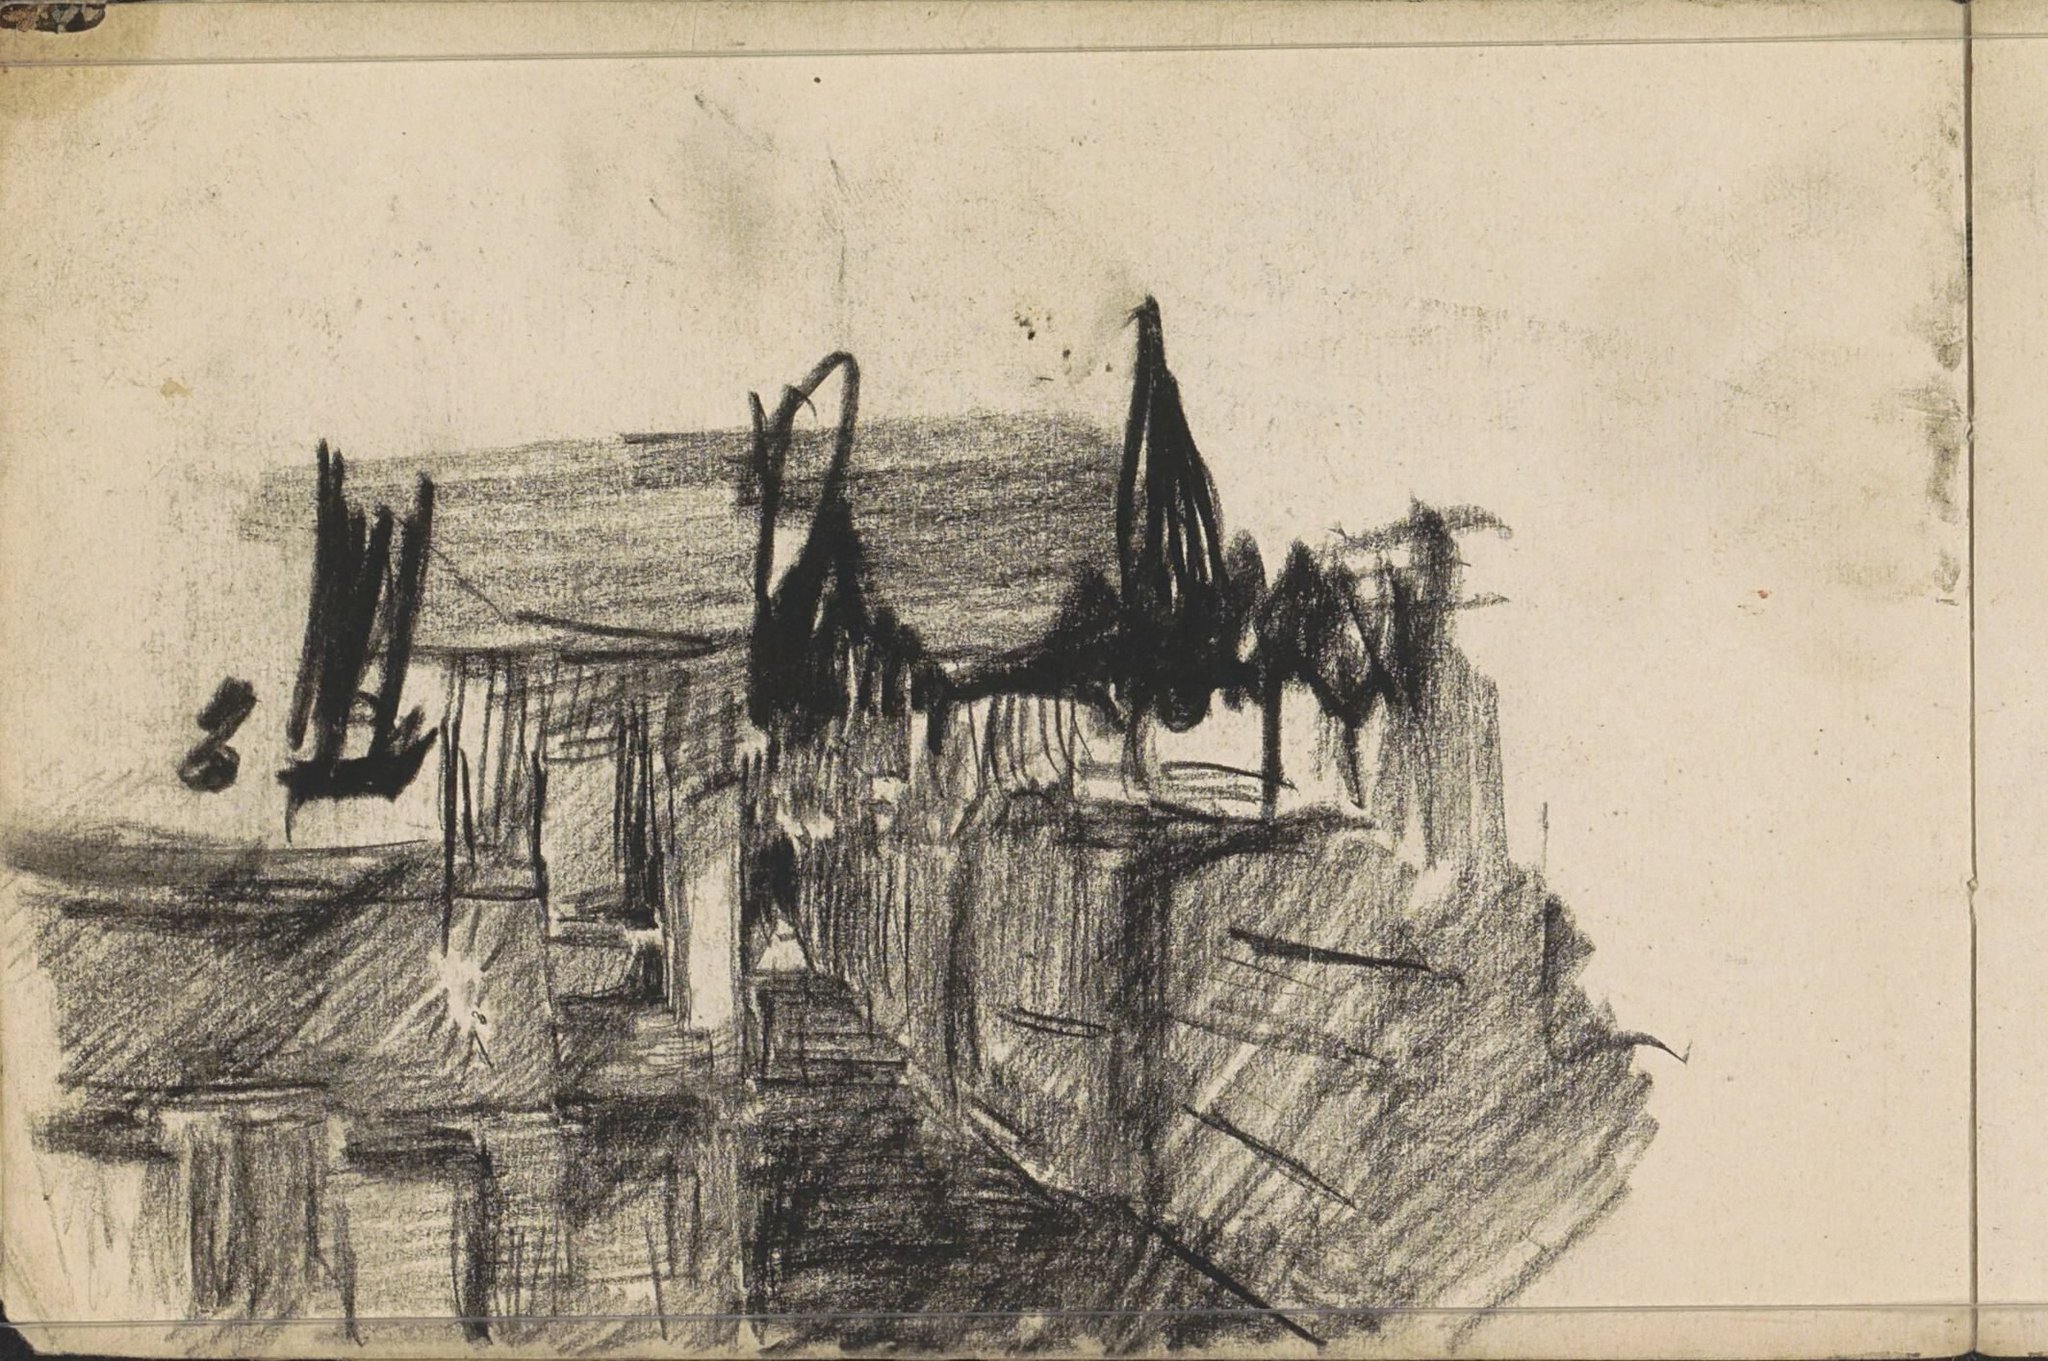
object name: sketchbook leaf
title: Straatgezicht met figuren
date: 1875-1934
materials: chalk, paper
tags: evening, street (+ city(-scape) with figures, staffage), paris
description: Mogelijk bij avond te Parijs. Pagina 4 uit schetsboek XLVI met 32 pagina's.